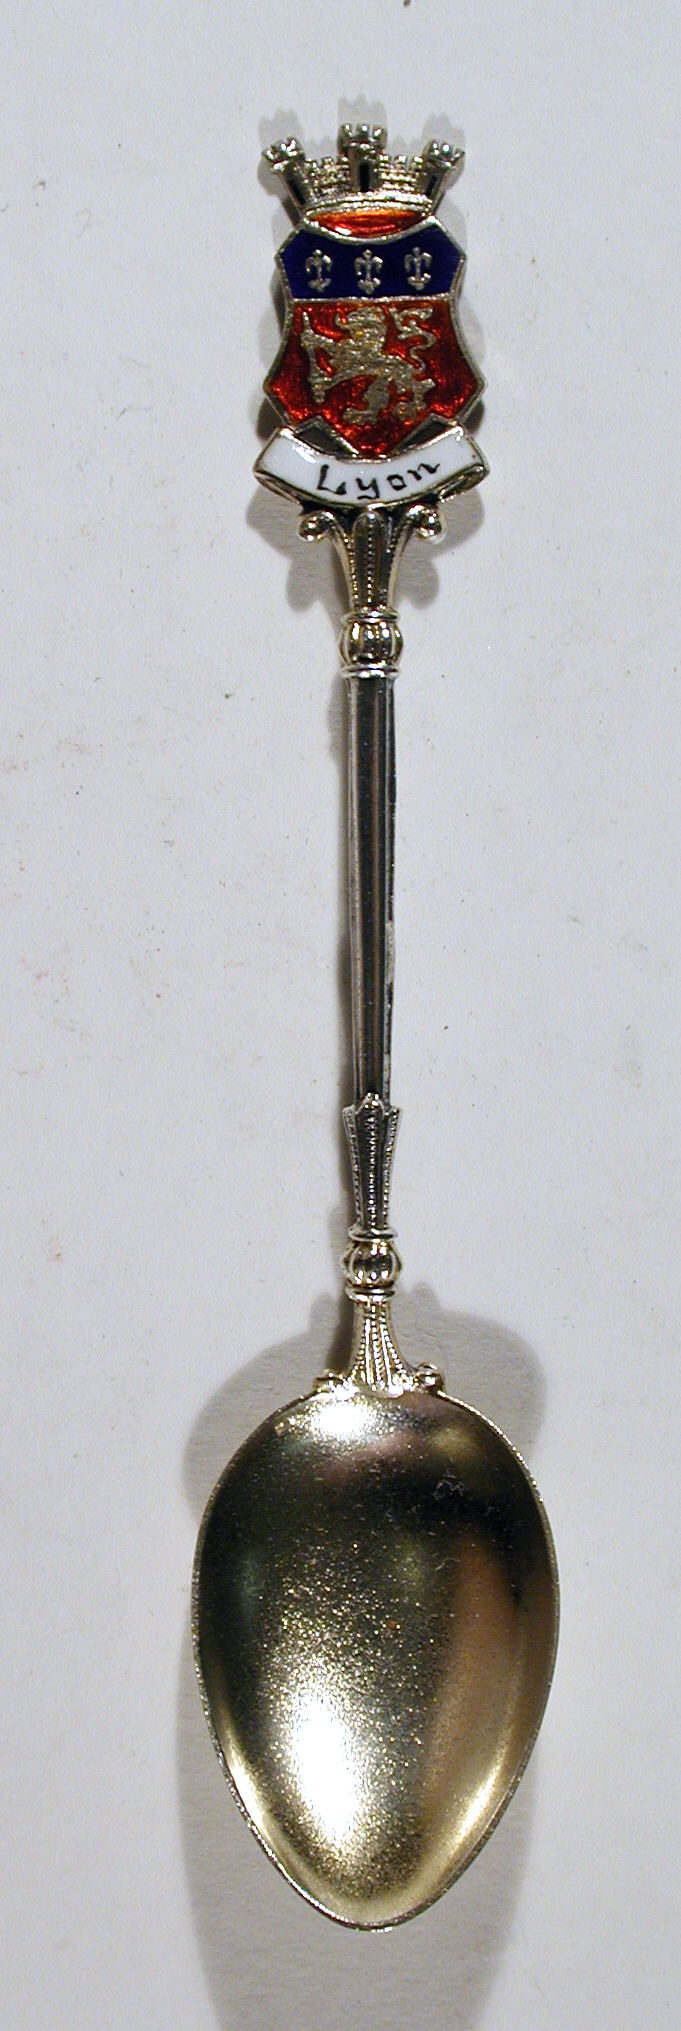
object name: souvenir spoon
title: Souvenir spoon with arms of Lyon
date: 1867-1900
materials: enamel, gilt, silver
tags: coat of arms